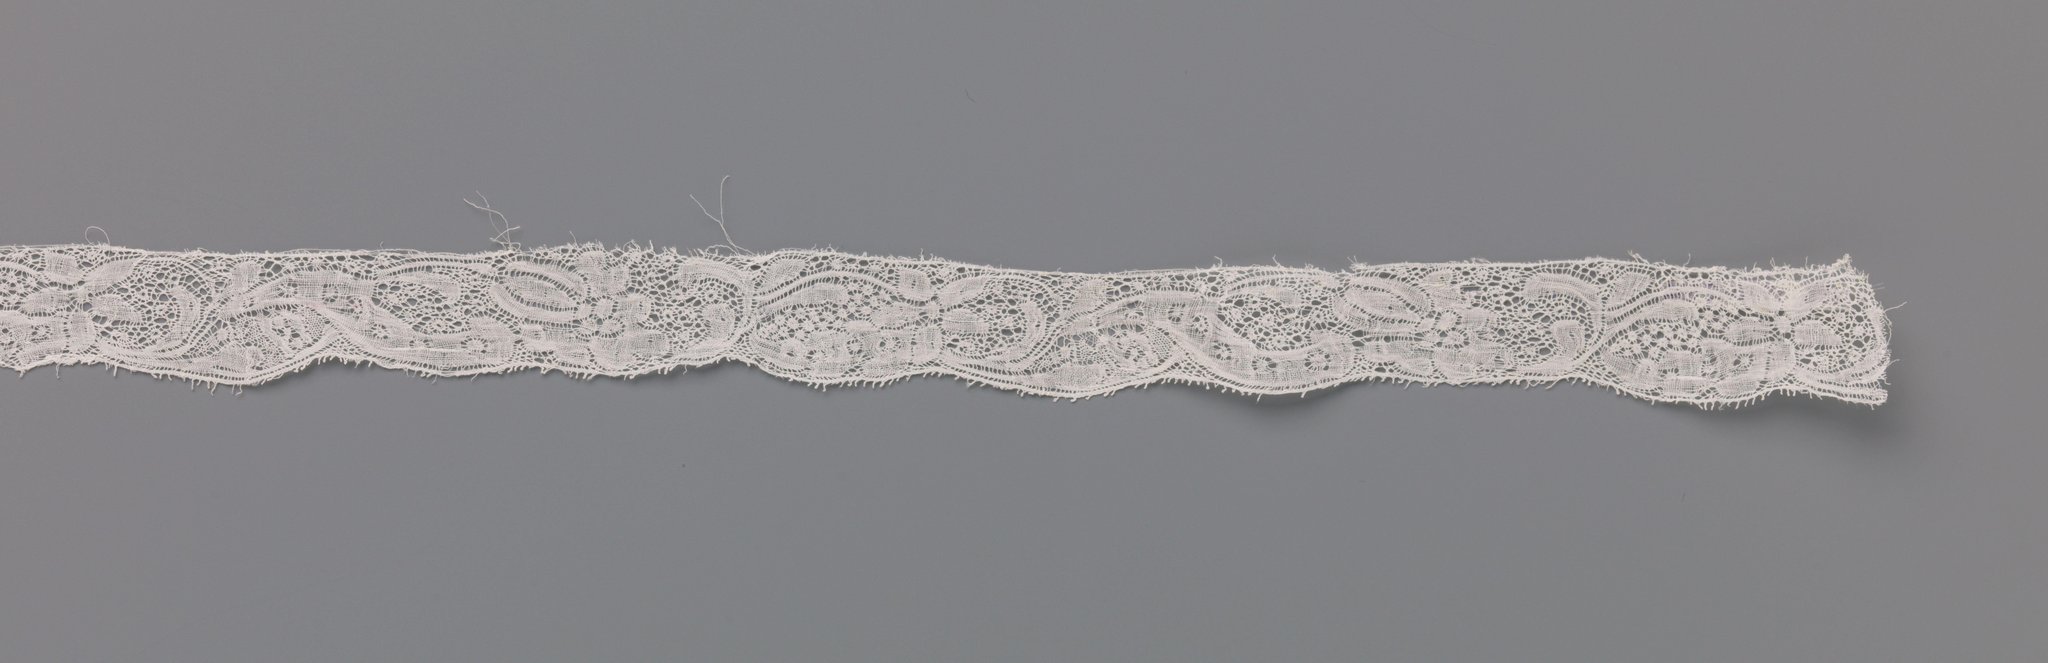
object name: strip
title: Strook kloskant met pluimvormige bloem en stervormige bloem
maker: Anonymous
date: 1700-1749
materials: linen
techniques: lace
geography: southern netherlands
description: Strook naturelkleurige kloskant, Binche-kant. Het zich herhalende en doorlopende patroon bestaat uit een pluimvormige bloem en een stervormigebloem met vijf puntige bloemblaadjes aan gebogen stengels. Tussen de opeenvolgende bloemen oversnijdt een golvend blad de stengel van de pluimvormige bloem. Onder de stengel van de stervormige bloem ligt langs de onderrand een dunne pluimvormige bloem of aar. De motieven zijn met elkaar verbonden door een fijne siergrond, een sneeuwvlokkengrond. De motieven zijn gemaakt in linnenslag met opengewerkte randjes en netslagvulling onder het golvende blad. De bovenzijde van de strook is recht afgewerkt. De flauwe schulpen langs de onderzijde van de strook komen voort uit het patroon en zijn afgewerkt met picots.